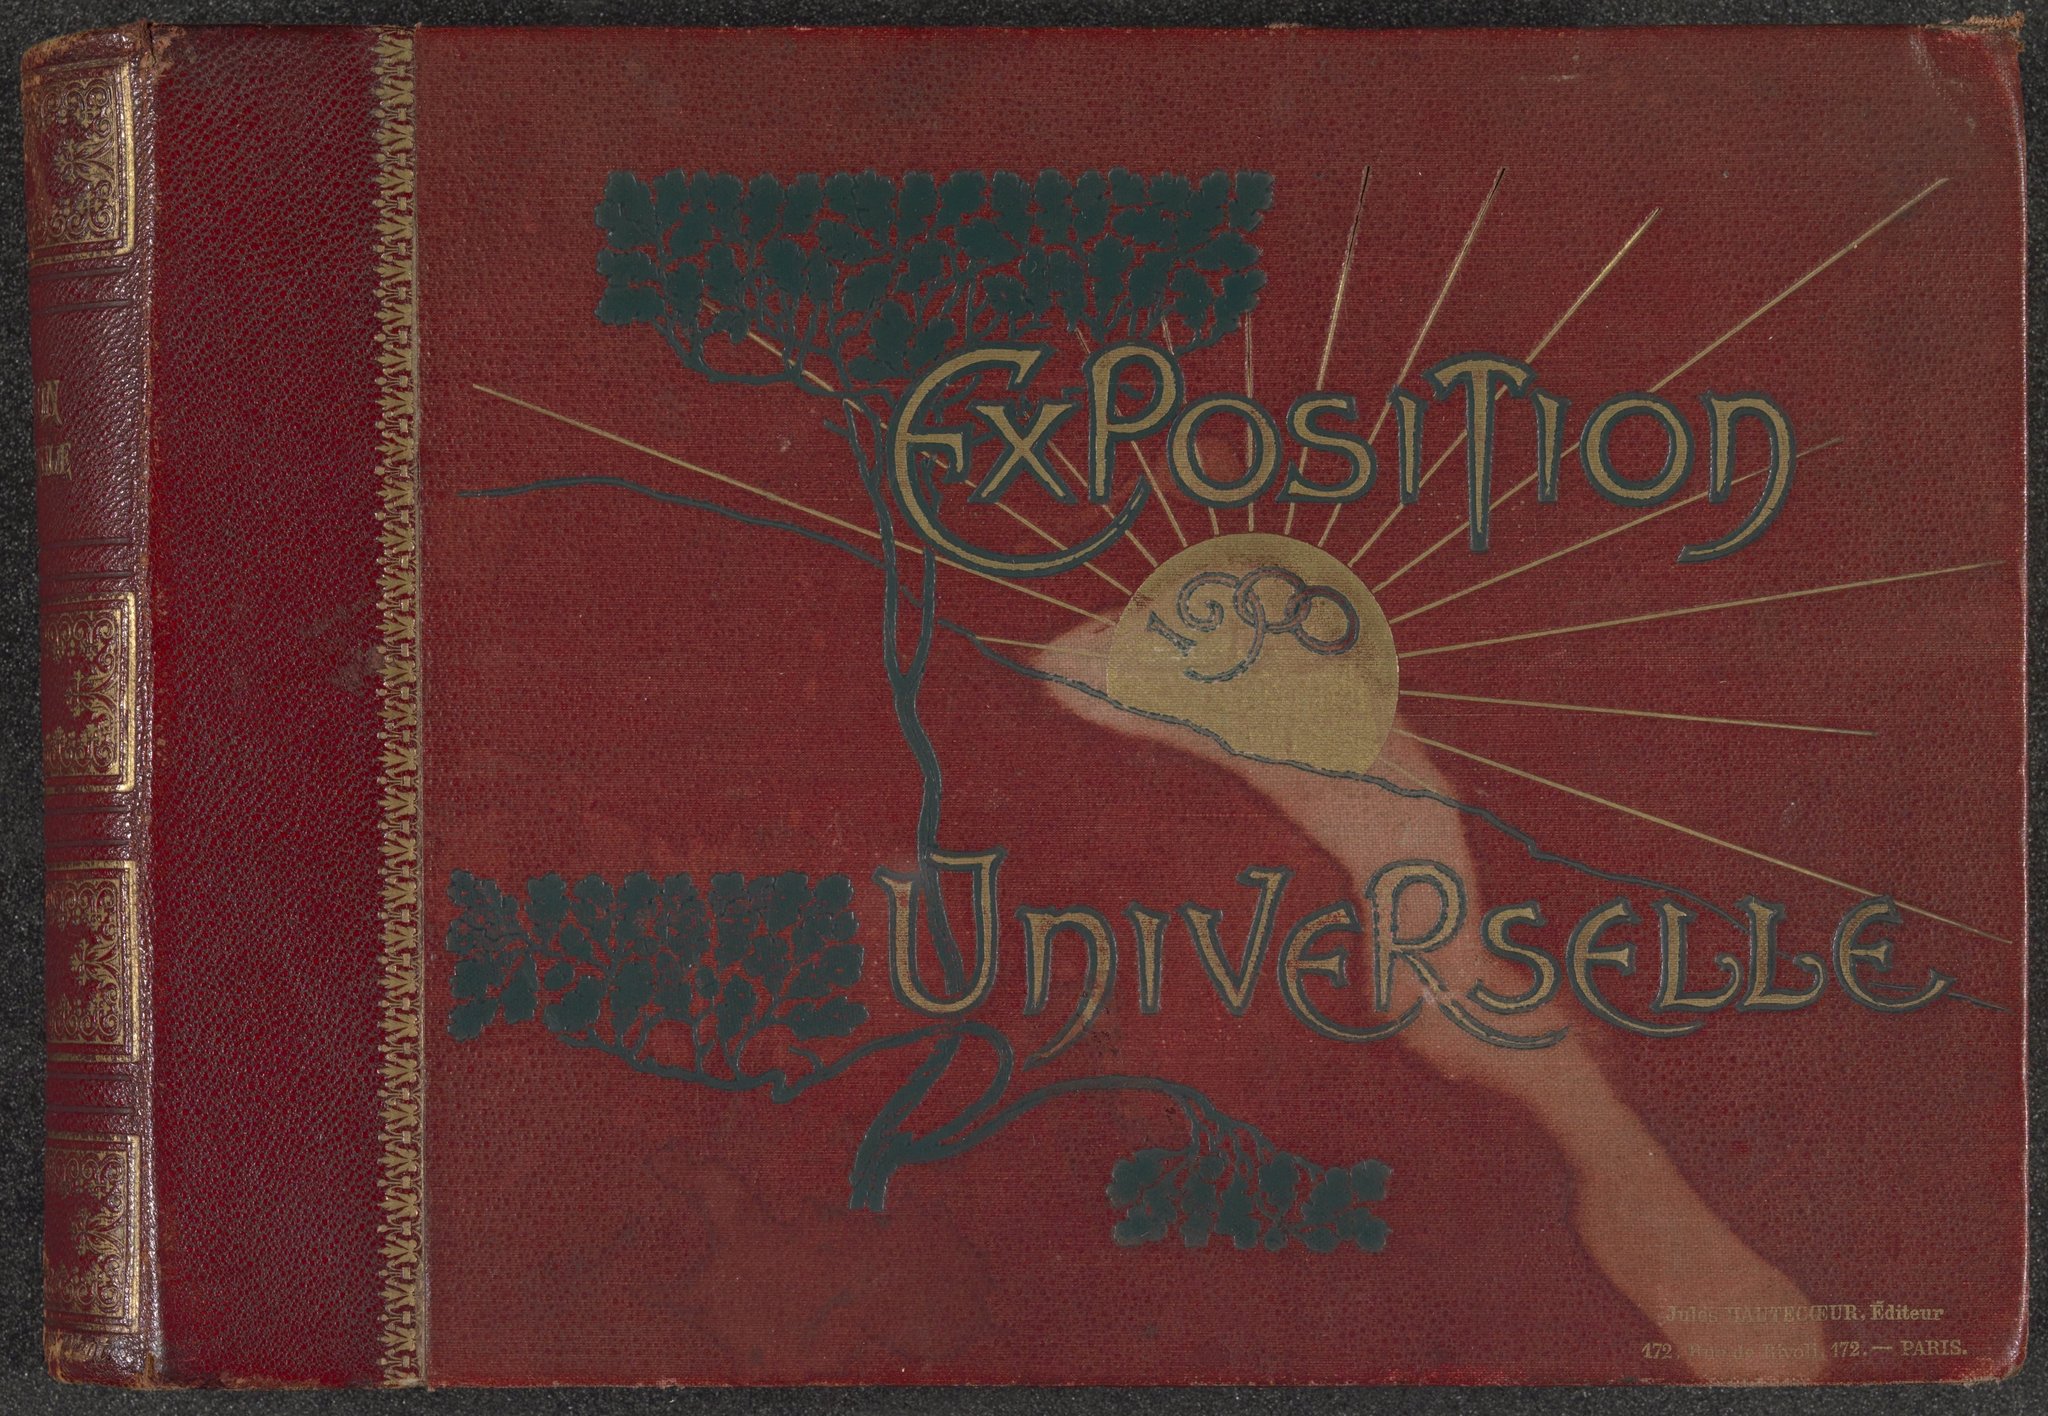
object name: photograph album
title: Fotoalbum met opnames van de Wereldtentoonstelling van 1900 in Parijs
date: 1900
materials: cardboard, leather, linen, paper, photographic support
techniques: albumen print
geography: paris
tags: world fair, world exhibition, prospect of city, town panorama, silhouette of city, paris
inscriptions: bookplate: ‘Ex-libris Leo Polak’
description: Fotoalbum in rode band. Op het voorplat een afbeelding van een stralende zon en een boom, de titel en de naam van de uitgever. Op de rug (onderaan) de naam van de fotografen en nogmaals de titel. De schutbladen hebben een geometrisch motief in goud en bruin. Het album bevat achttien dikke bladen met goud op snee waarop in totaal 36 afdrukken zijn geplakt. Het zijn opnames gemaakt tijdens de Wereldtentoonstelling van 1900 in Parijs. In beeld worden onder andere gebracht het Grand en het Petit Palais, de Pont Alexandre-III over de Seine, de Avenue des Palais, de Esplanade des Invalides, de Palais des Nations (landenpaviljoens) aan de Rue des Nations, het Palais des Machines, het Palais du Trocadéro, het Parc du Champ de Mars en de Eiffeltoren. Ook de bewegende loopbanden waarmee bezoekers over het expositieterrein werden vervoerd, destijds een noviteit, komen aan de orde.